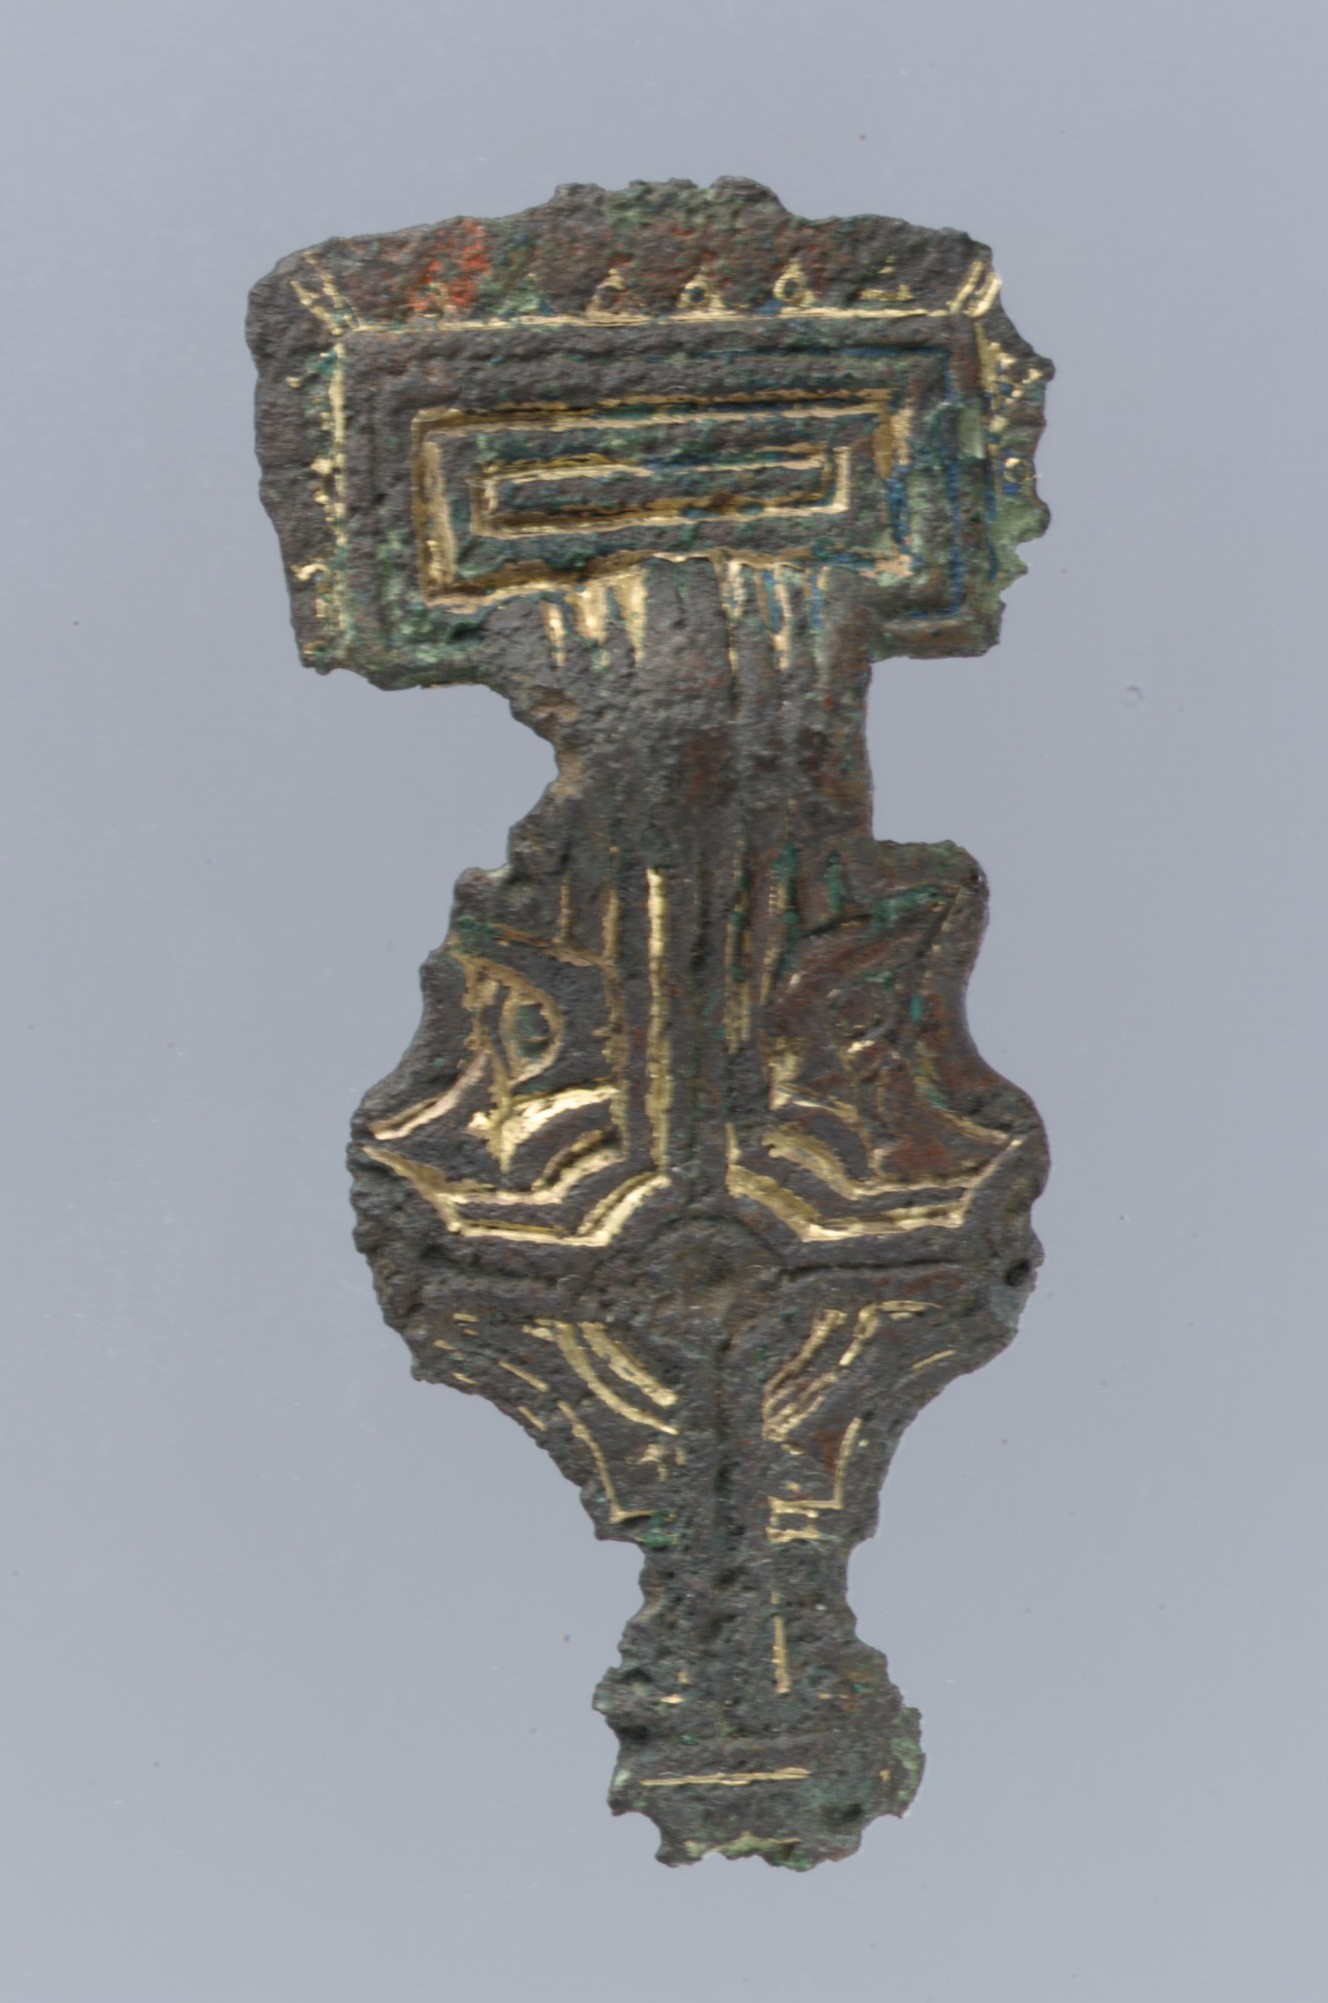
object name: brooch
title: Square-Headed Brooch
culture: anglo-saxon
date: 501-550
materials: iron, silver gilt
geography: england